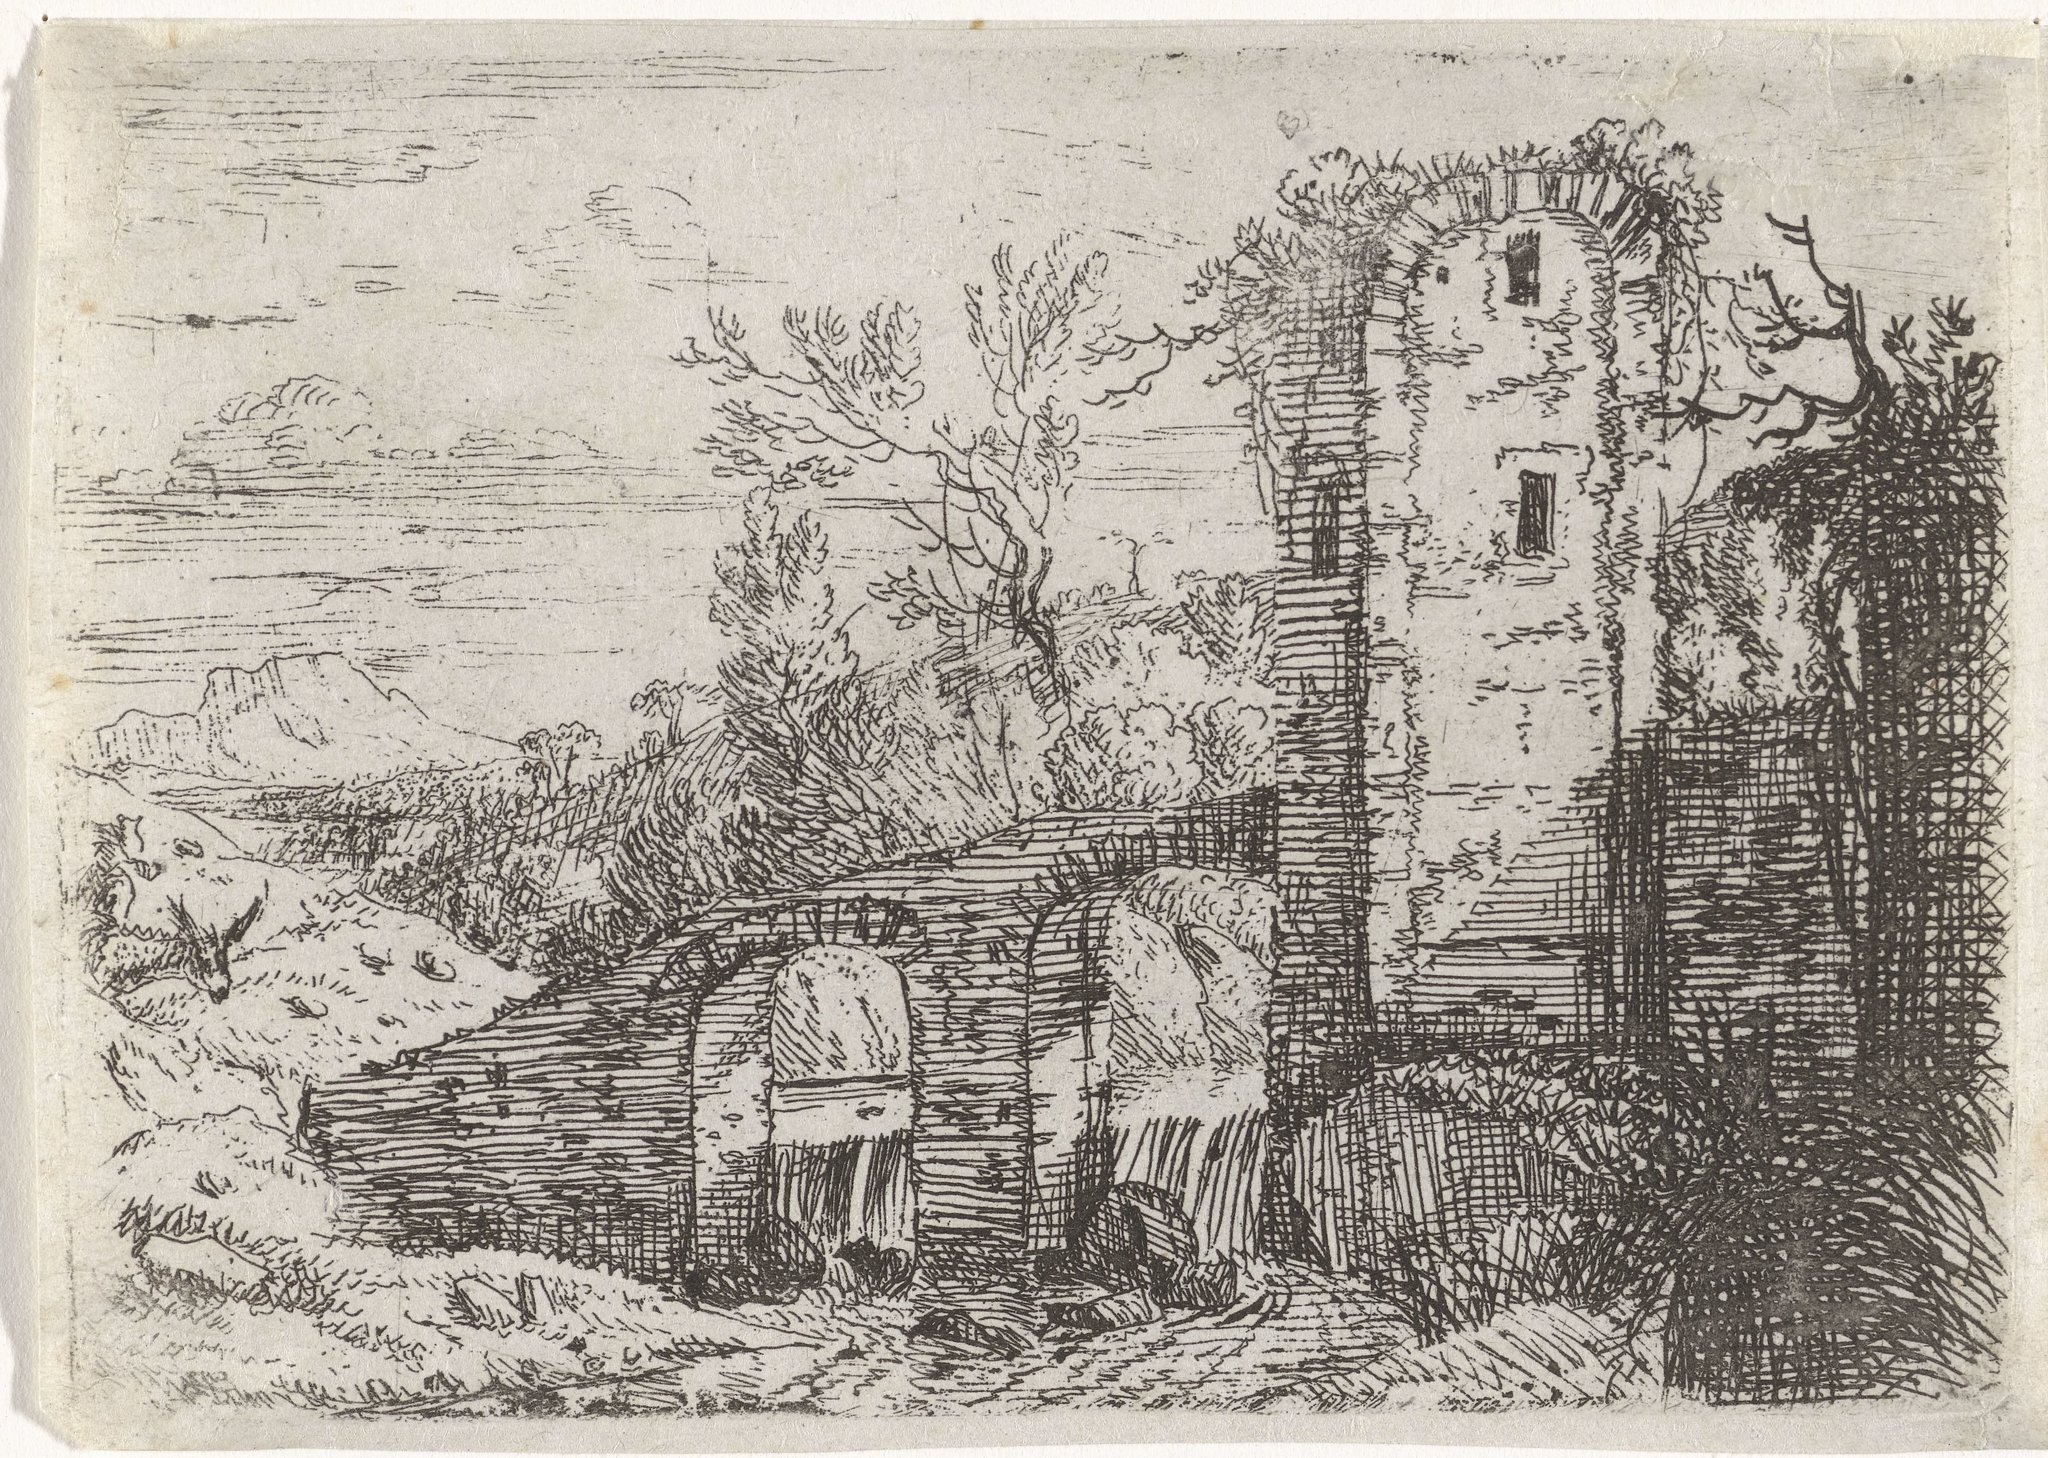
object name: print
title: Stenen brug over waterval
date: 1665-1721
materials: paper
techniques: etching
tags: waterfall, landscape with bridge, viaduct or aqueduct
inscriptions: collector's mark: Lugt 2228, collector's mark: Lugt 2610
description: Een stenen brug met twee bogen over een waterval. Rechts komt de brug uit in een toren.